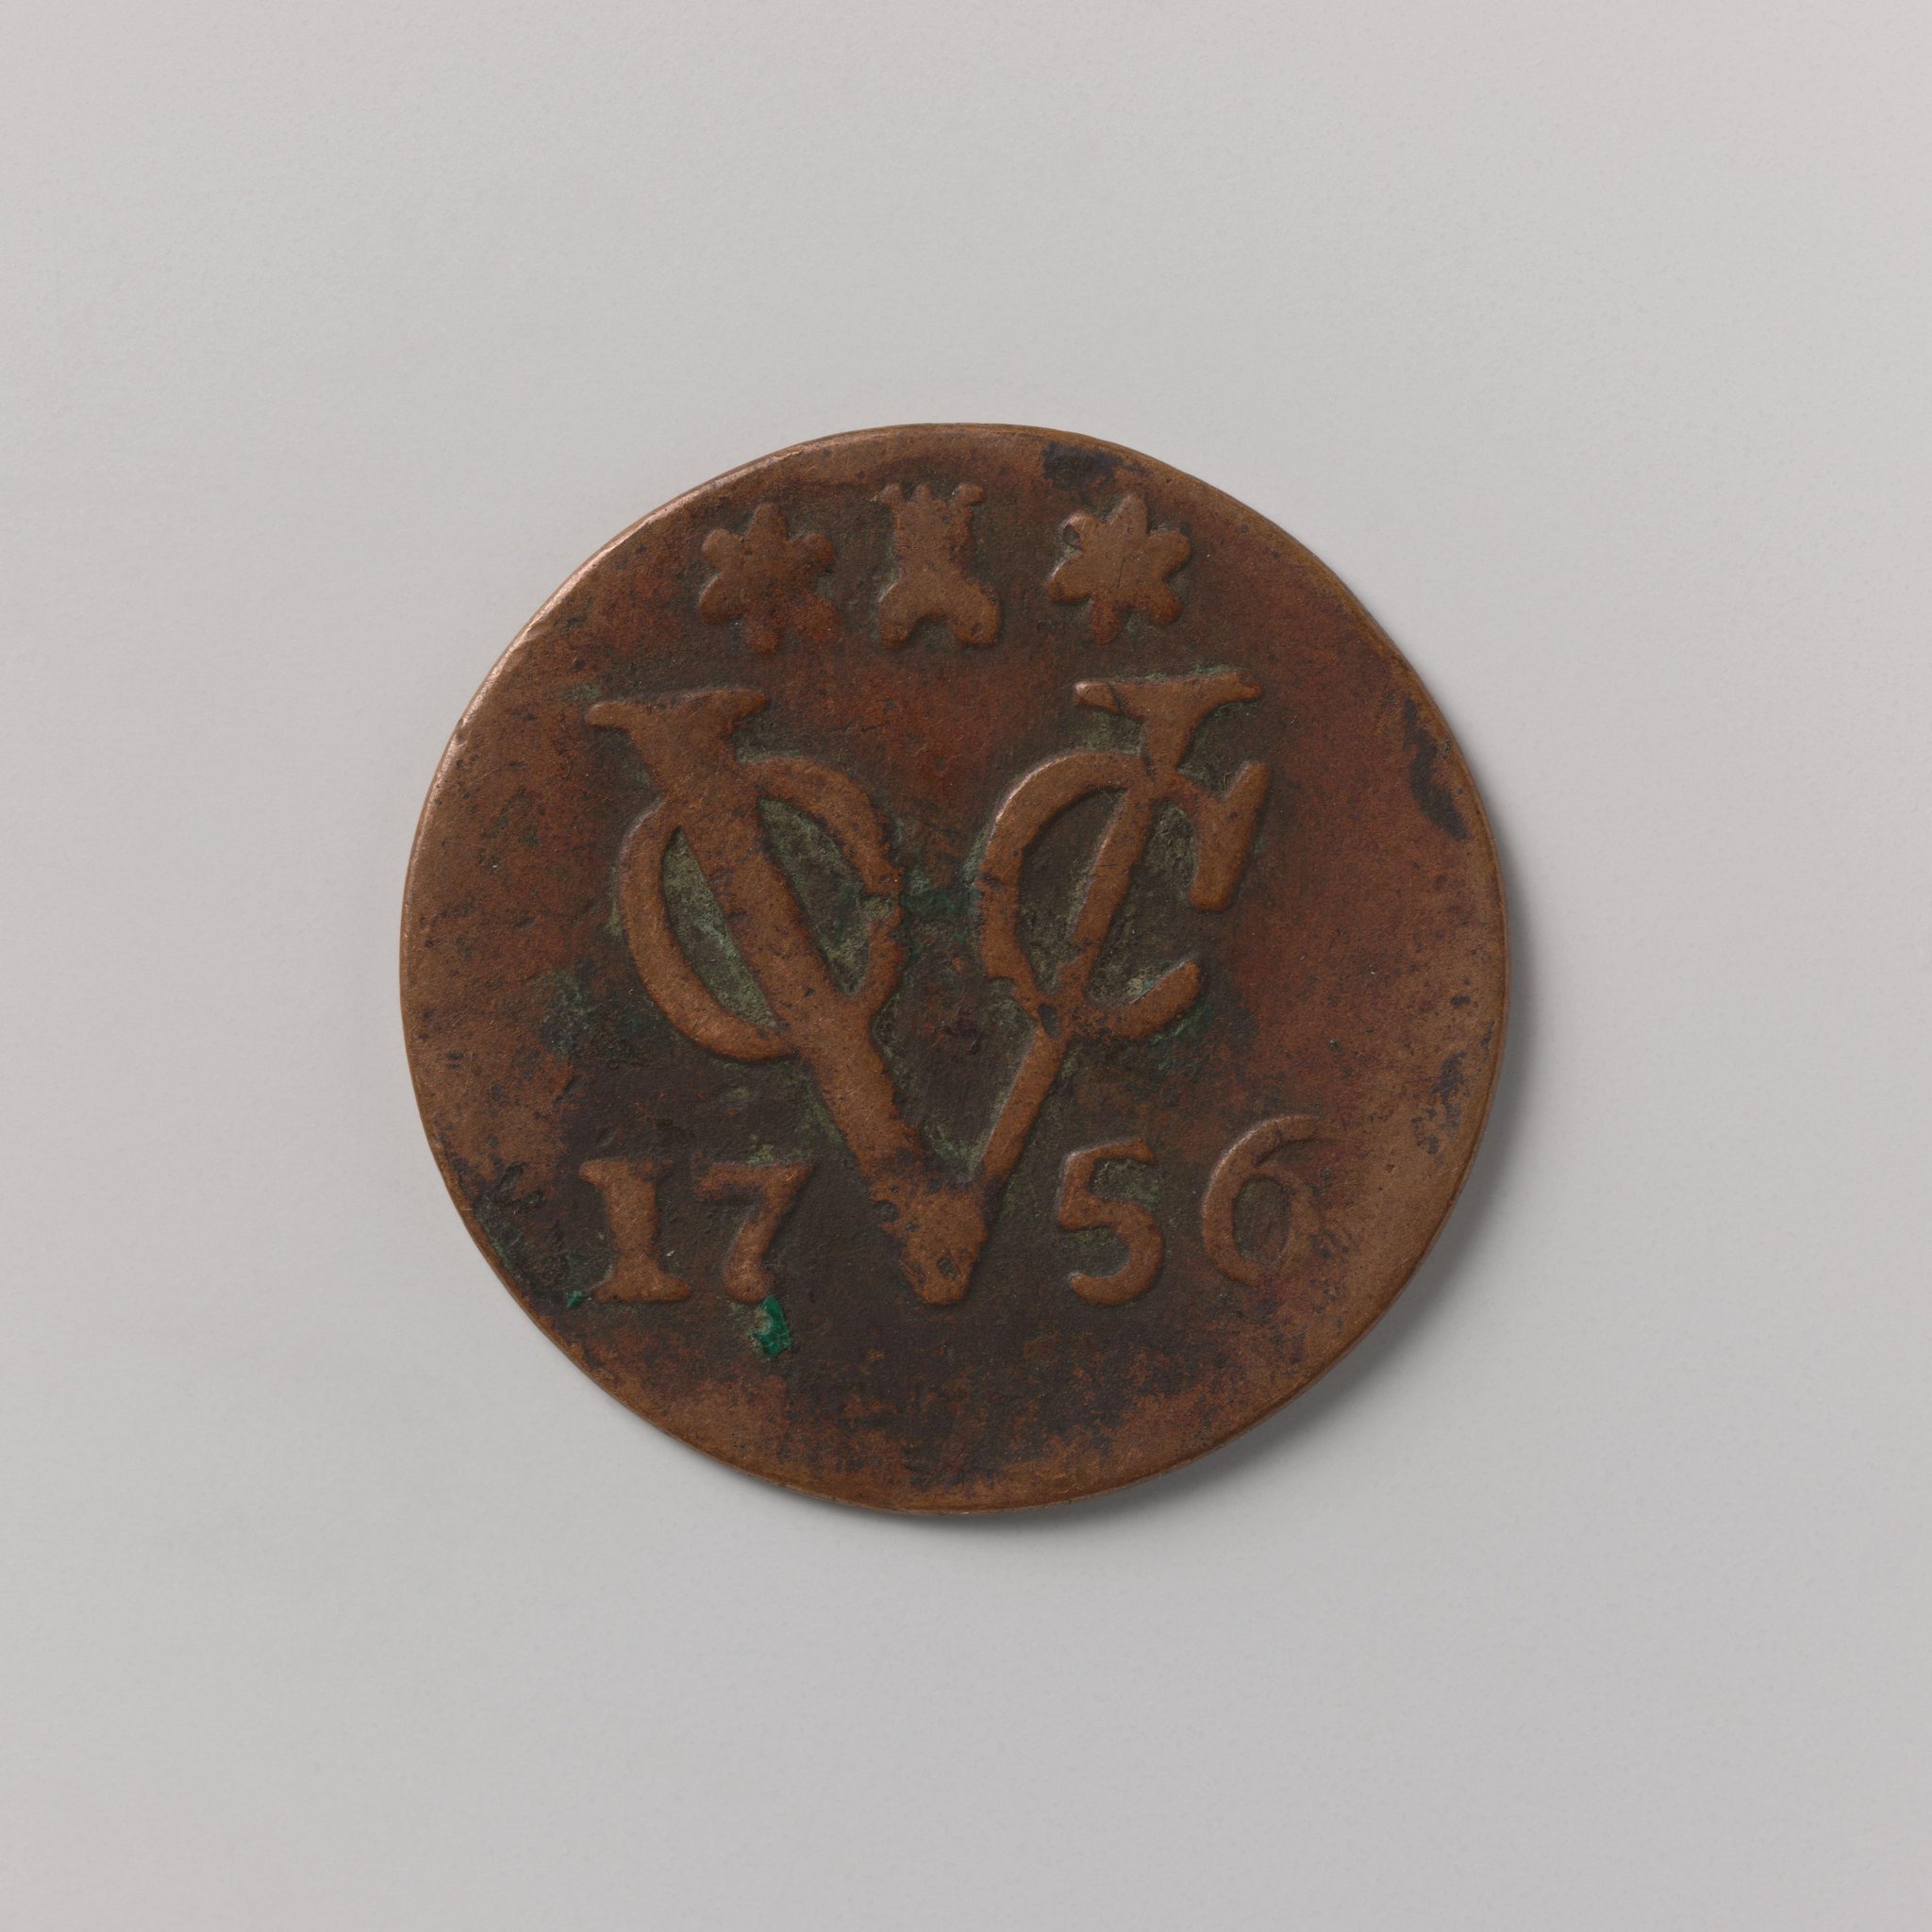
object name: coin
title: Duit van de VOC uit Zeeland, 1756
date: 1756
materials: copper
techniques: striking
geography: middelburg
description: Koperen munt. Voorzijde: gekroond wapenschild van Zeeland. Keerzijde: monogram van de VOC, waarboven muntteken en waaronder jaartal. Gladde rand.